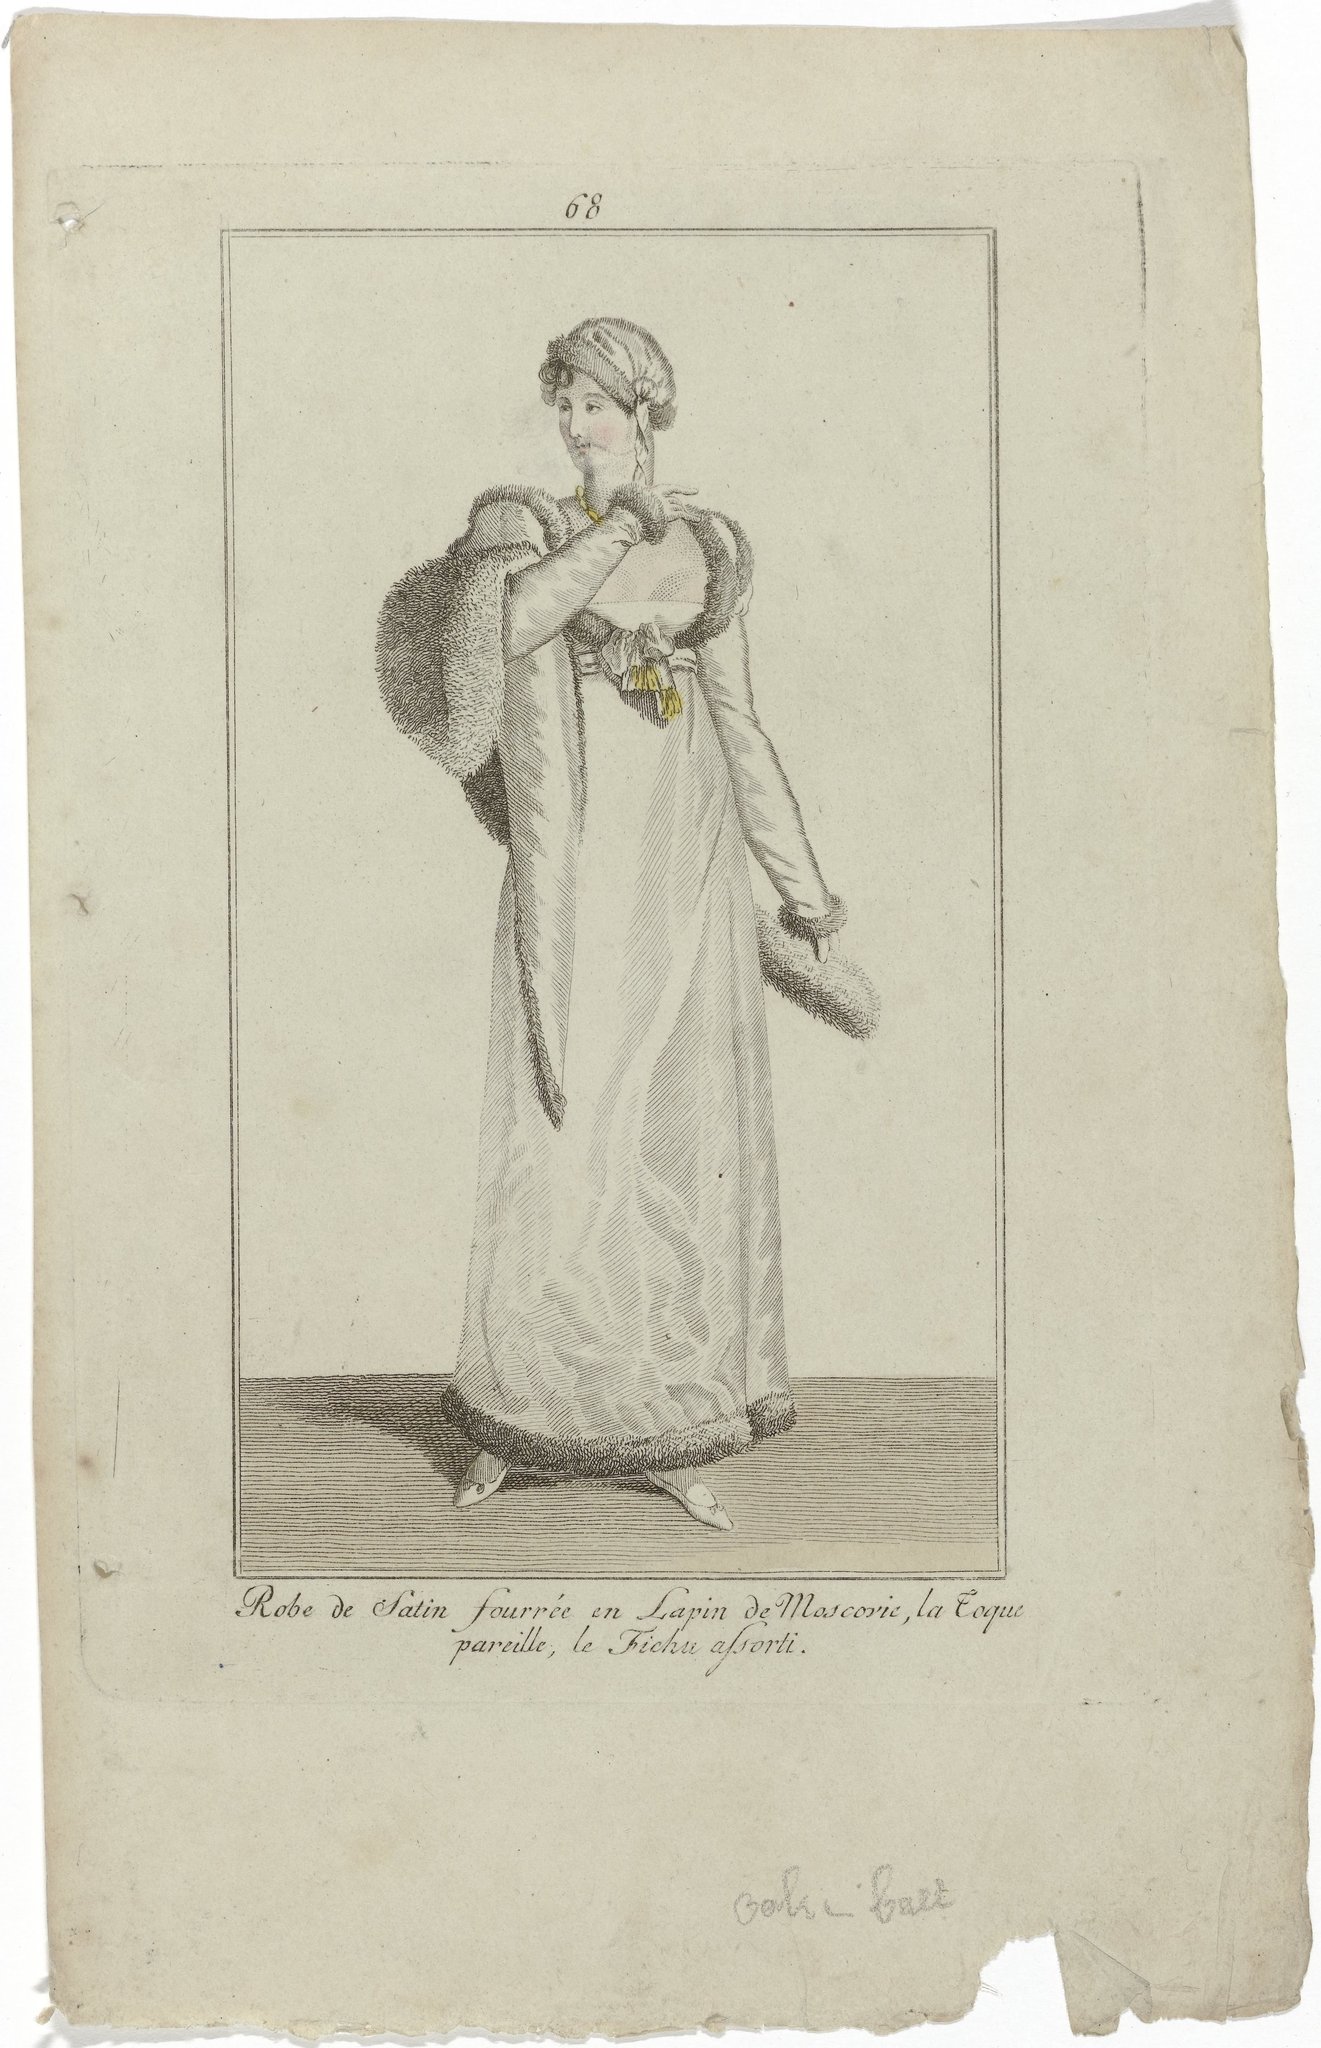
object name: fashion print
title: Elegantia, of tijdschrift van mode, luxe en smaak voor dames, Januari 1809, No. 68 : Robe de Satin (...)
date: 1808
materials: paper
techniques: engraving, hand coloring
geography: amsterdam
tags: head-gear: toque (+ women's clothes), border, ribbon, braid (+ fur used for clothes), piece of clothing covering the breast or décolleté (fichu) (+ fur used for clothes), fashion plates, shoes, sandals (+ women's clothes), dress, gown (+ women's clothes), piece of clothing covering the breast or décolleté (fichu) (+ women's clothes)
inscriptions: caption: ‘Robe de satin fourrée en Lapin de Moscovie, la Toque pareille, le Fichu assorti.’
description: Volgens de begeleidende tekst in het tijdschrift (p. 32): Wit satijnen japon met bont van 'Moskovisch konijn'. Toque en fichu van hetzelfde. Prent uit het modetijdschrift Elegantia, of tijdschrift van mode, luxe en smaak voor dames 1807-1814 (onderbroken door de periode 1811-1813).